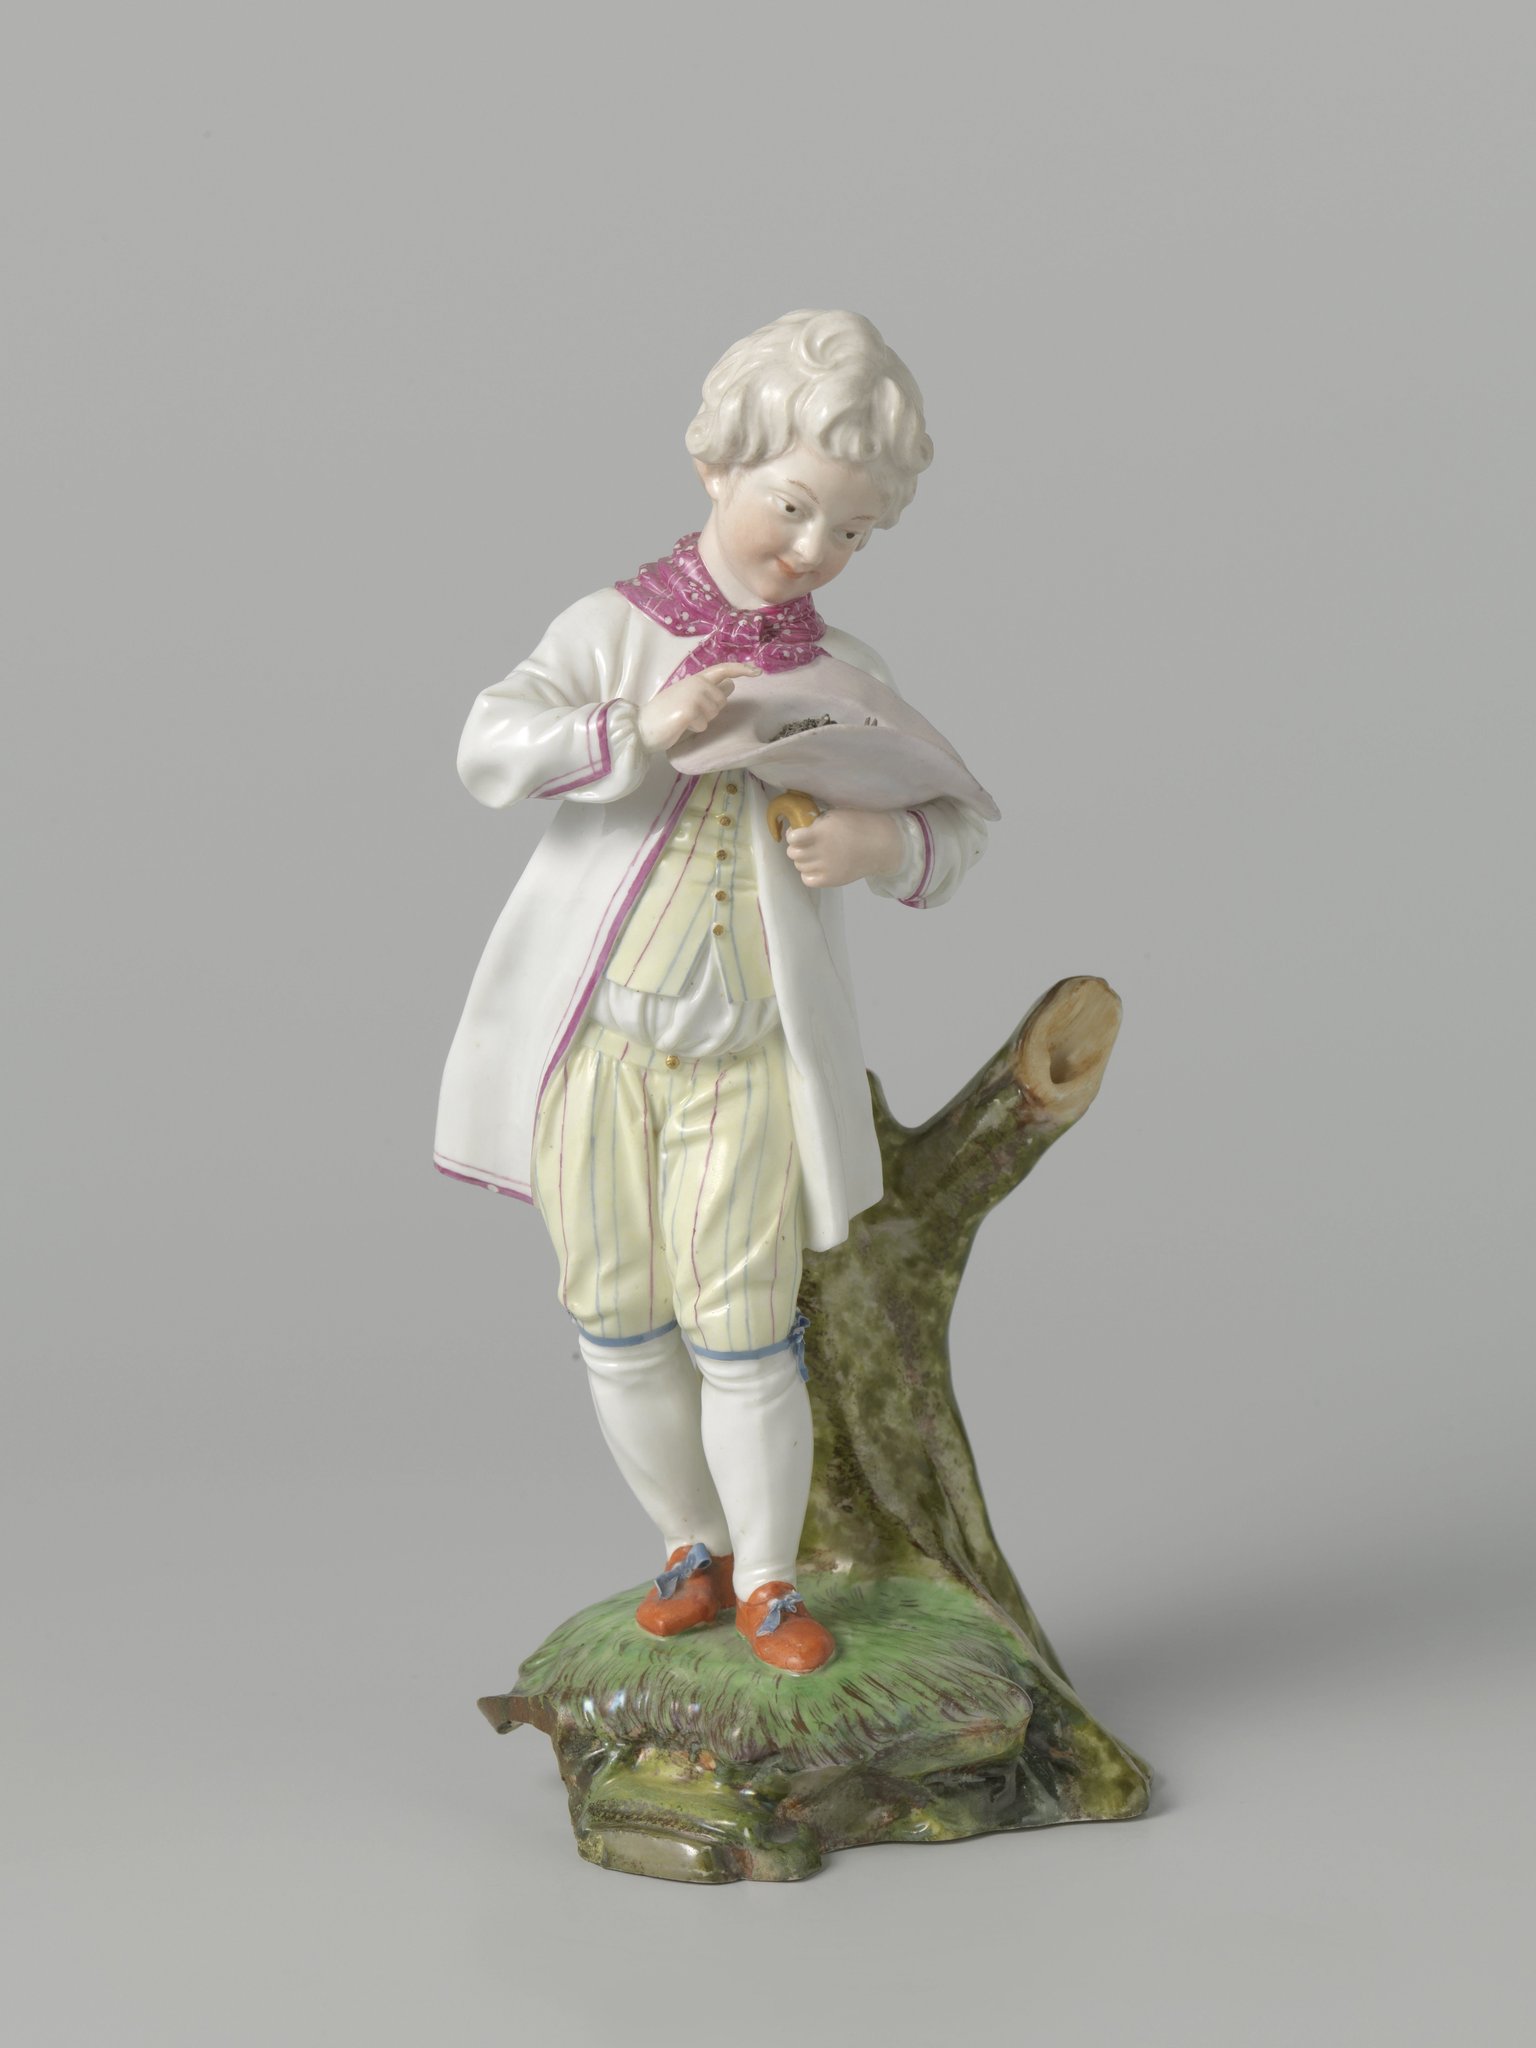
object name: figure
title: Figure of a boy with a bird's nest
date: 1762-1767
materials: glaze, gold, paint, porcelain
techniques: firing, forming, gilding, vitrification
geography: höchst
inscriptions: mark: ‘wiel/ M’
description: Figure. Porcelain. Höchst, c. 1762 - 1767, model after an engraving by Gottlieb Lebrecht Crusius. Given by C.P. van Eeghen, 1908.